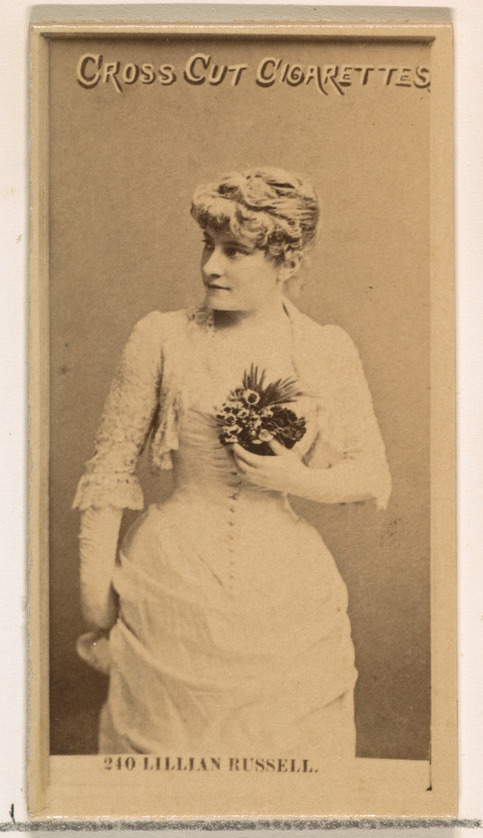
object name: print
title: Card Number 240, Lillian Russell, from the Actors and Actresses series (N145-2) issued by Duke Sons & Co. to promote Cross Cut Cigarettes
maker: w. duke, sons & co.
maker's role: publisher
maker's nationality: american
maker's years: 1870-1920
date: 1880-1889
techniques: albumen silver print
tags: women,actresses